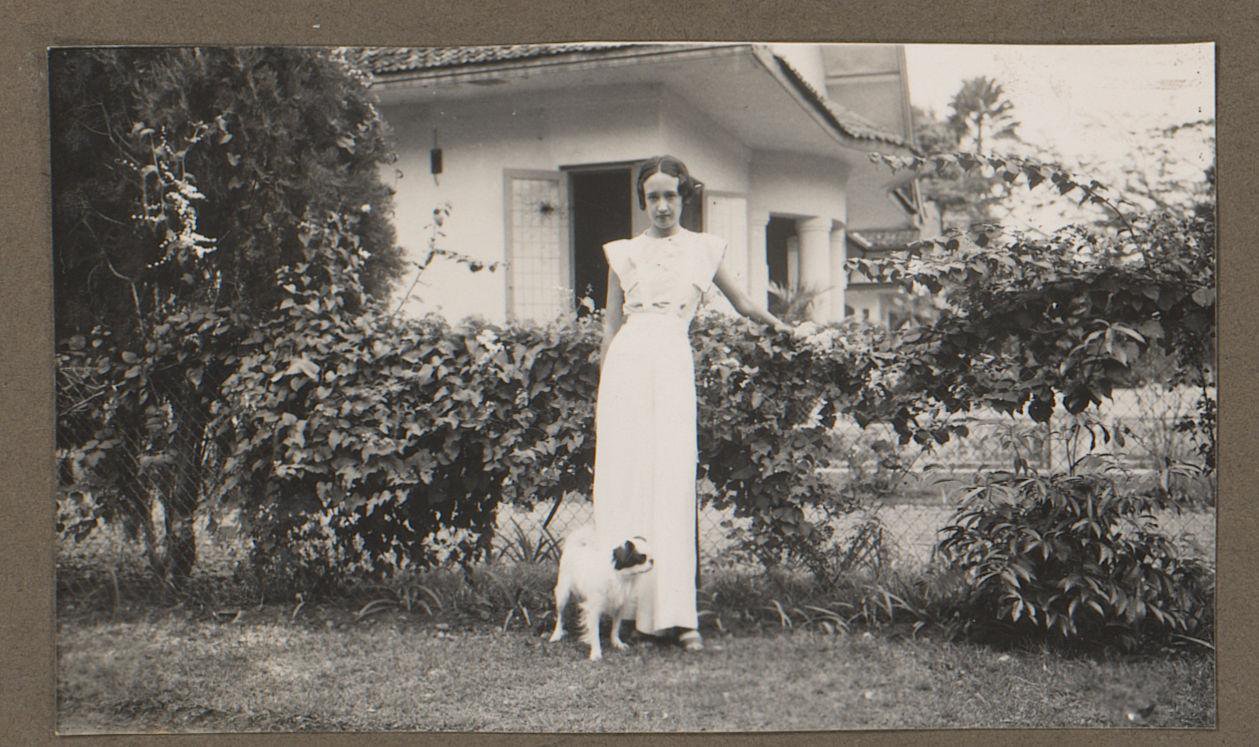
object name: photograph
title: Portret van Dootje met een hond in een tuin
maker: Anonymous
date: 1934-1935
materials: paper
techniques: gelatin silver print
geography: dutch east indies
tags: amsterdam, historical persons - bb - woman, dog, dutch east indies, the